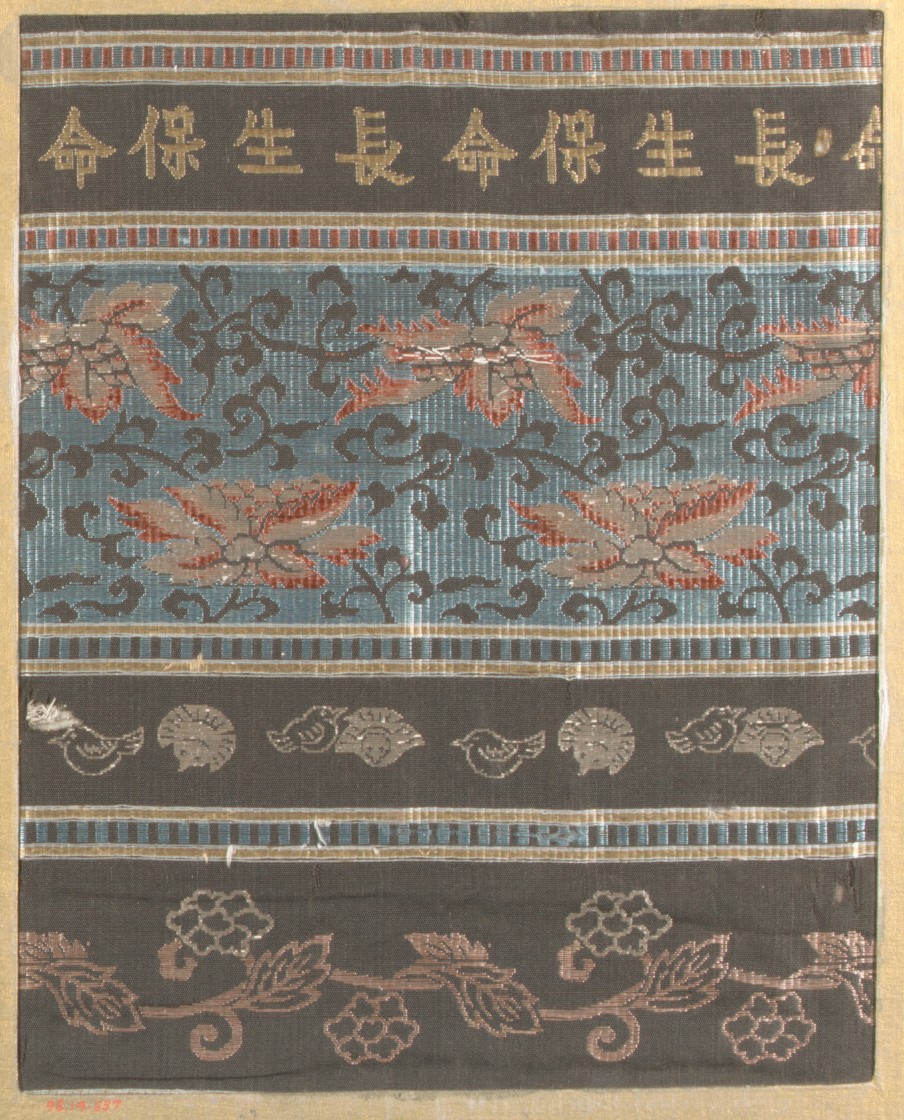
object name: piece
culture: japanese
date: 1701-1900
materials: silk